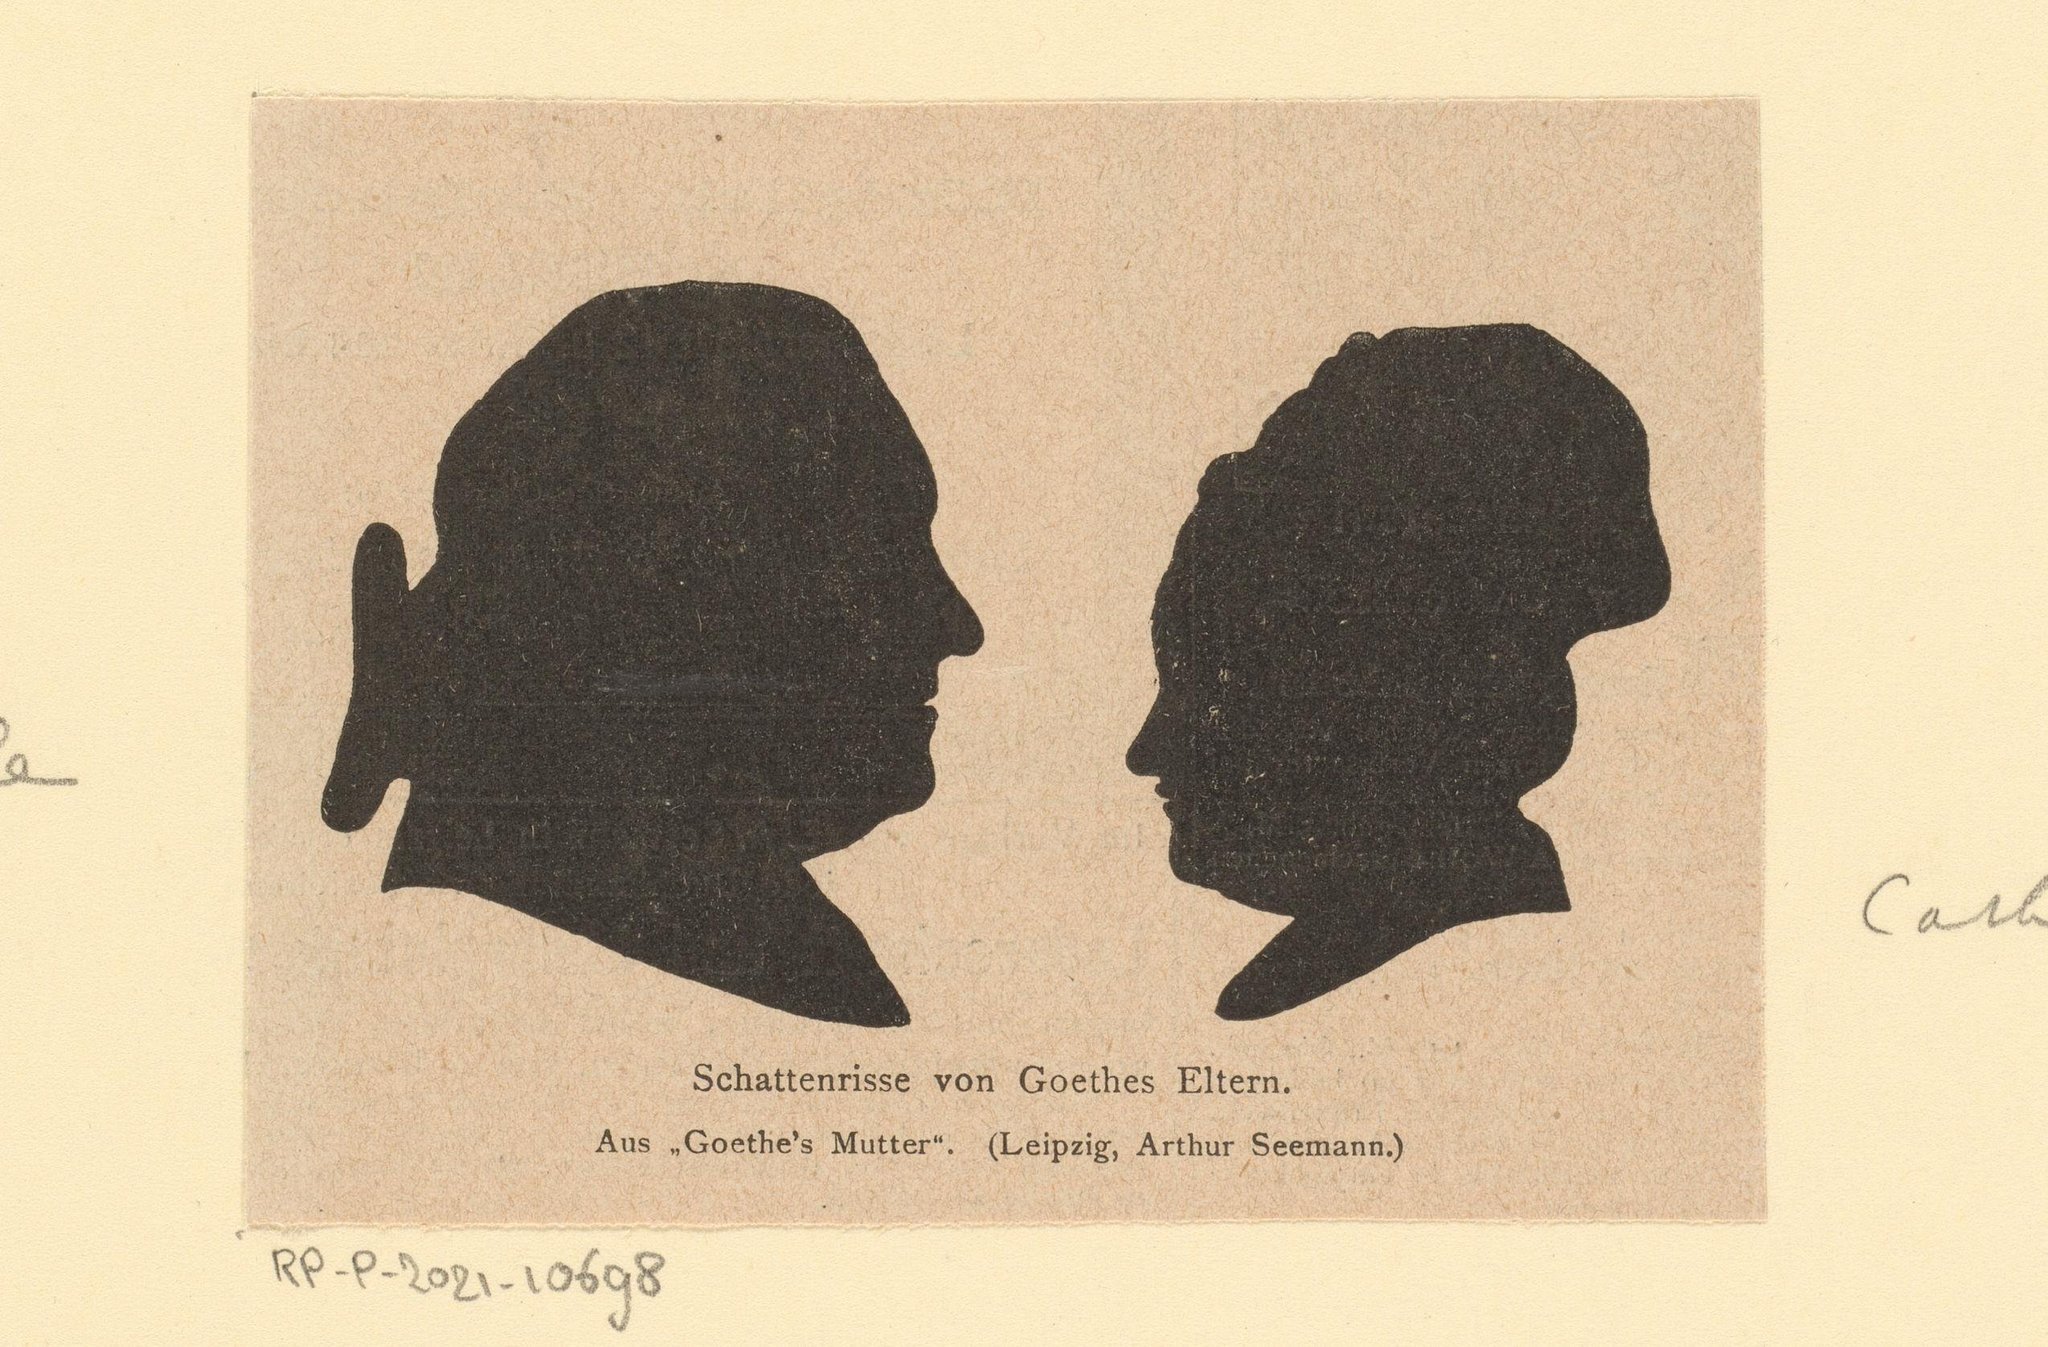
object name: photomechanical print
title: Silhouetportretten van Johann Caspar Goethe en Catharina Elisabeth Goethe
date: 1891-1893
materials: paper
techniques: letterpress printing, printing block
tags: historical persons - bb - woman, historical persons